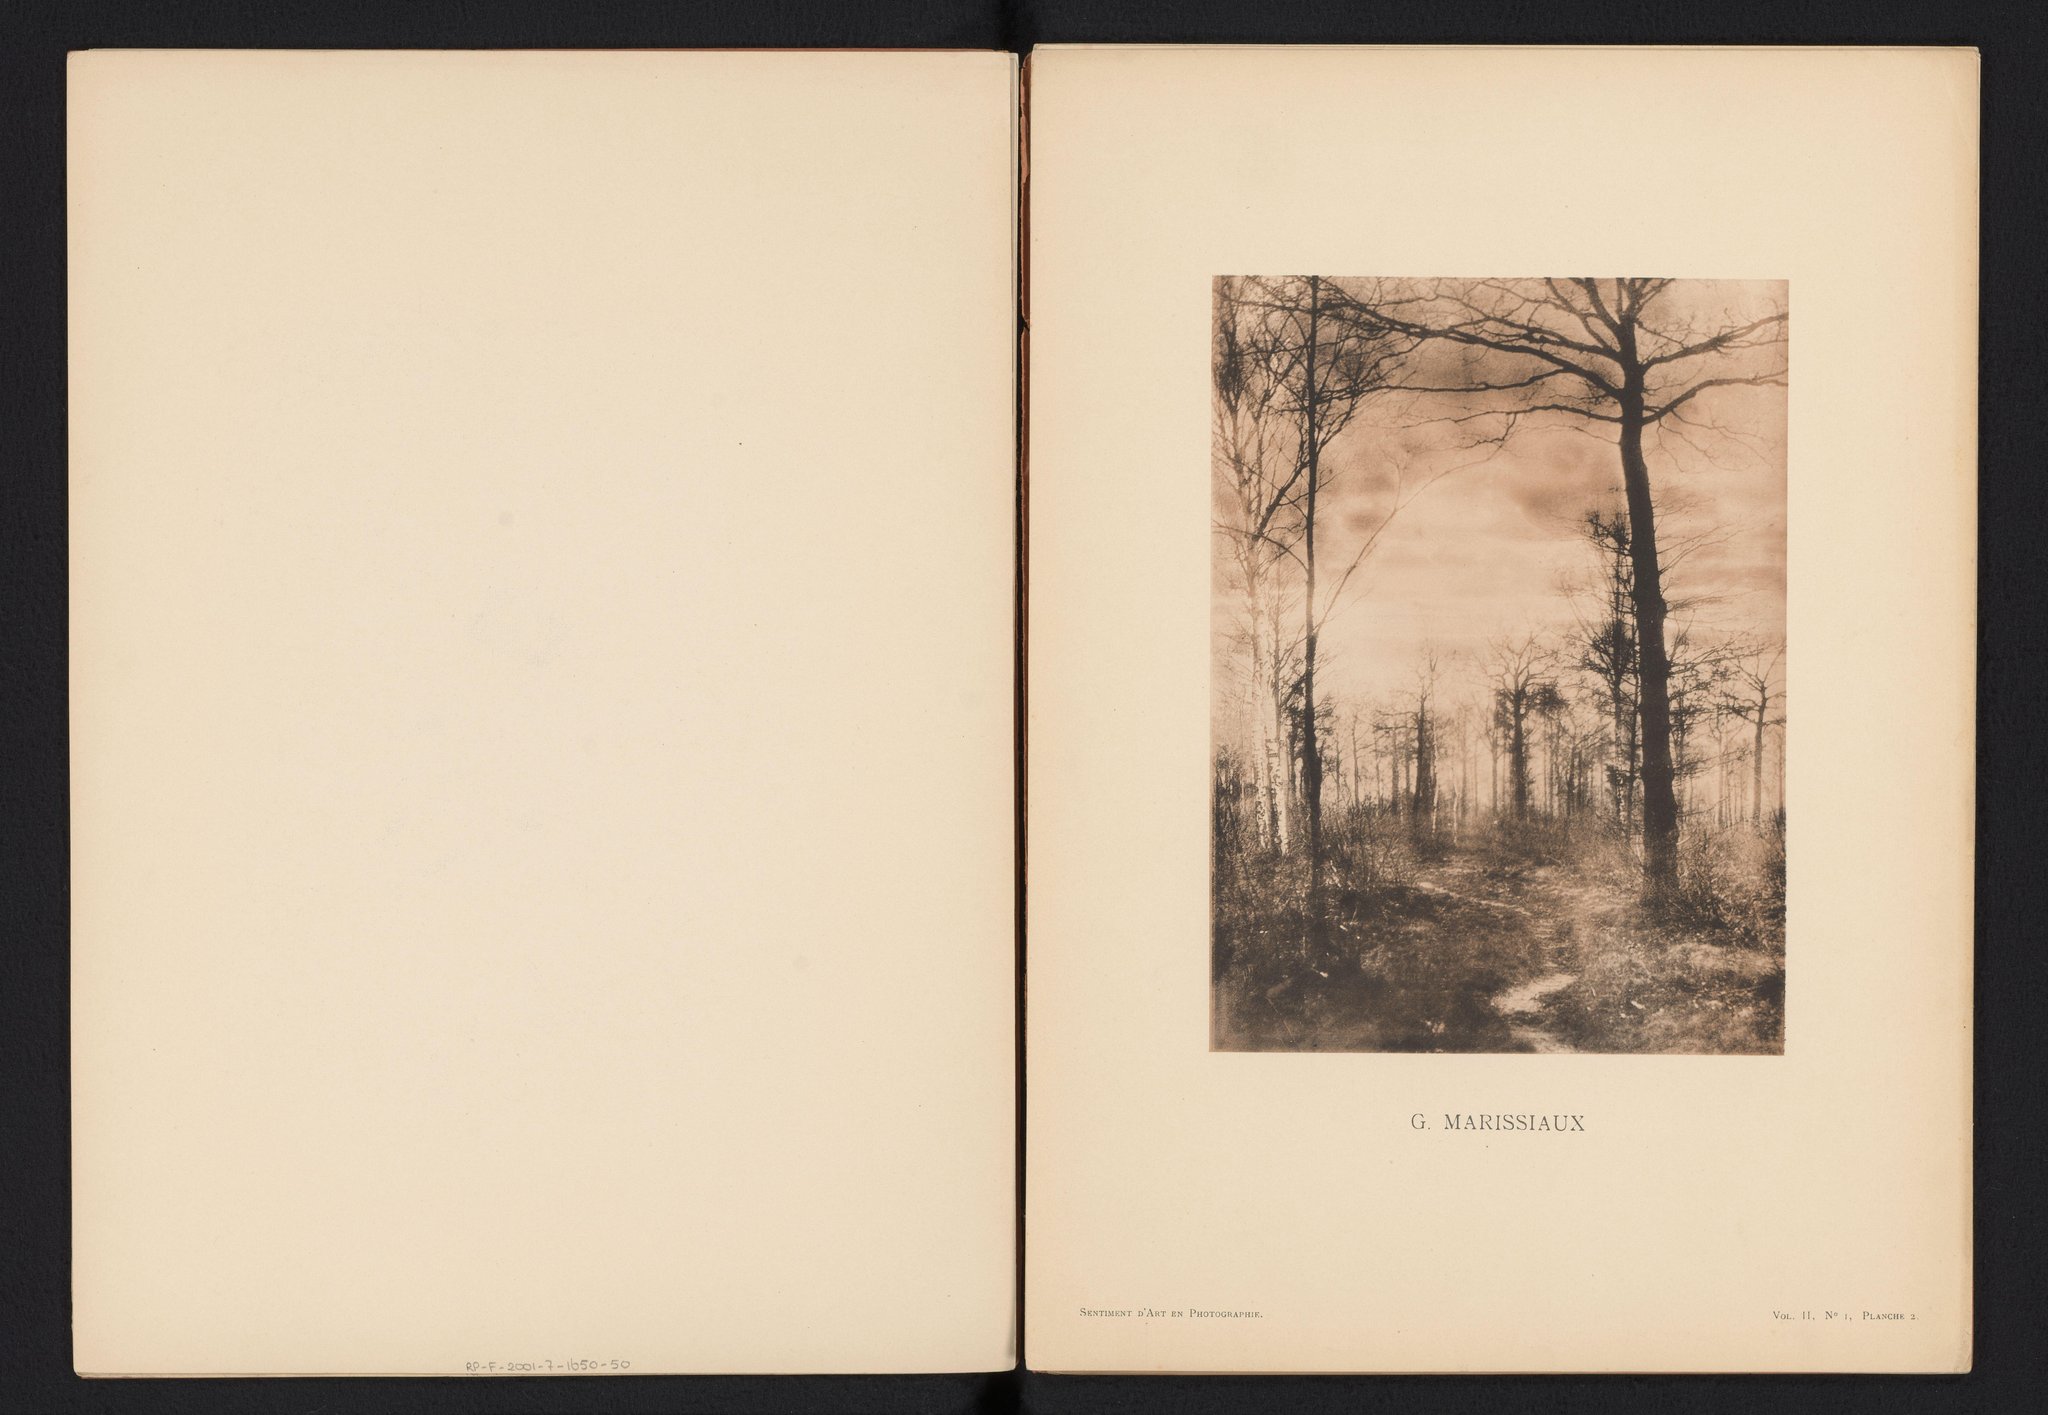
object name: photomechanical print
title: Landschap met bomen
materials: paper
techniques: photograph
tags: trees, landscapes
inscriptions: number: ‘Vol. II, No 1, Planche 2.’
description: Deze prent maakt deel uit van 8 omslagen met 22 tekstbladen en 89 prenten op losse bladen in en tussen de omslagen.